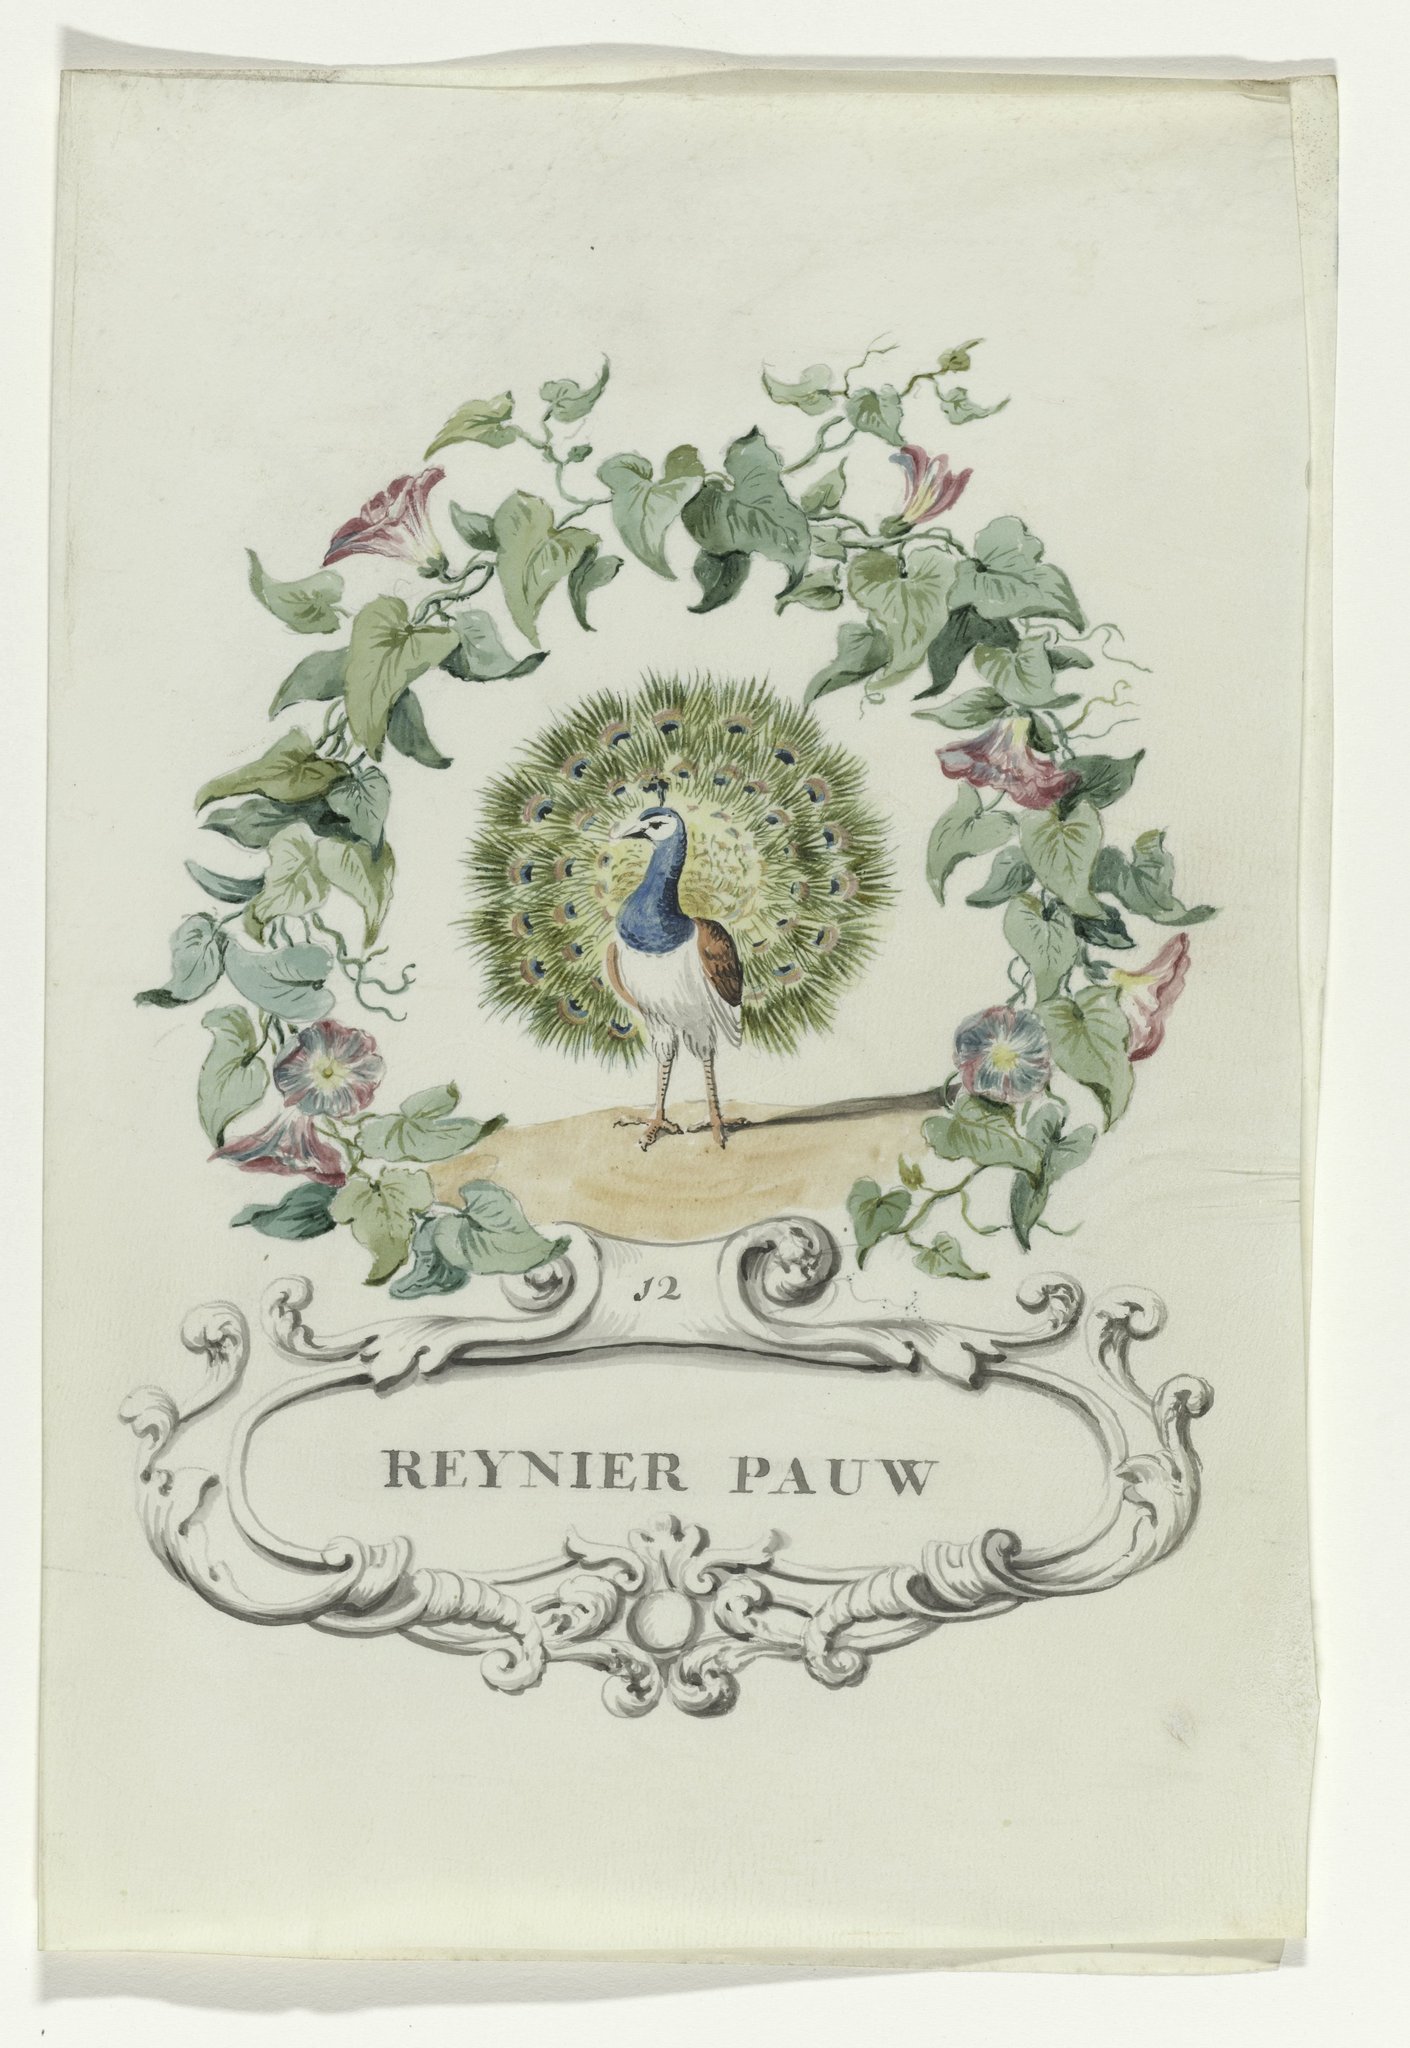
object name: drawing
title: Regtspleging van Oldenbarnevelt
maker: Anonymous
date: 1710-1720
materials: ink, parchment, watercolor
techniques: brush, pen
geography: netherlands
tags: the hague, johan van oldenbarnevelt, amsterdam, mayor, caricatures (human types), bad, corrupt judge, ornamental birds: peacock, political caricatures and satires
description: Spotprent van Reynier Pauw, rechter van Van Oldenbarnevelt; pauw met uitgespreide staart, in krans van bloemen en bladeren. Daaronder cartouche waarin naam en daarboven nr. 12. Behorende bij serie aquarellen in boek.